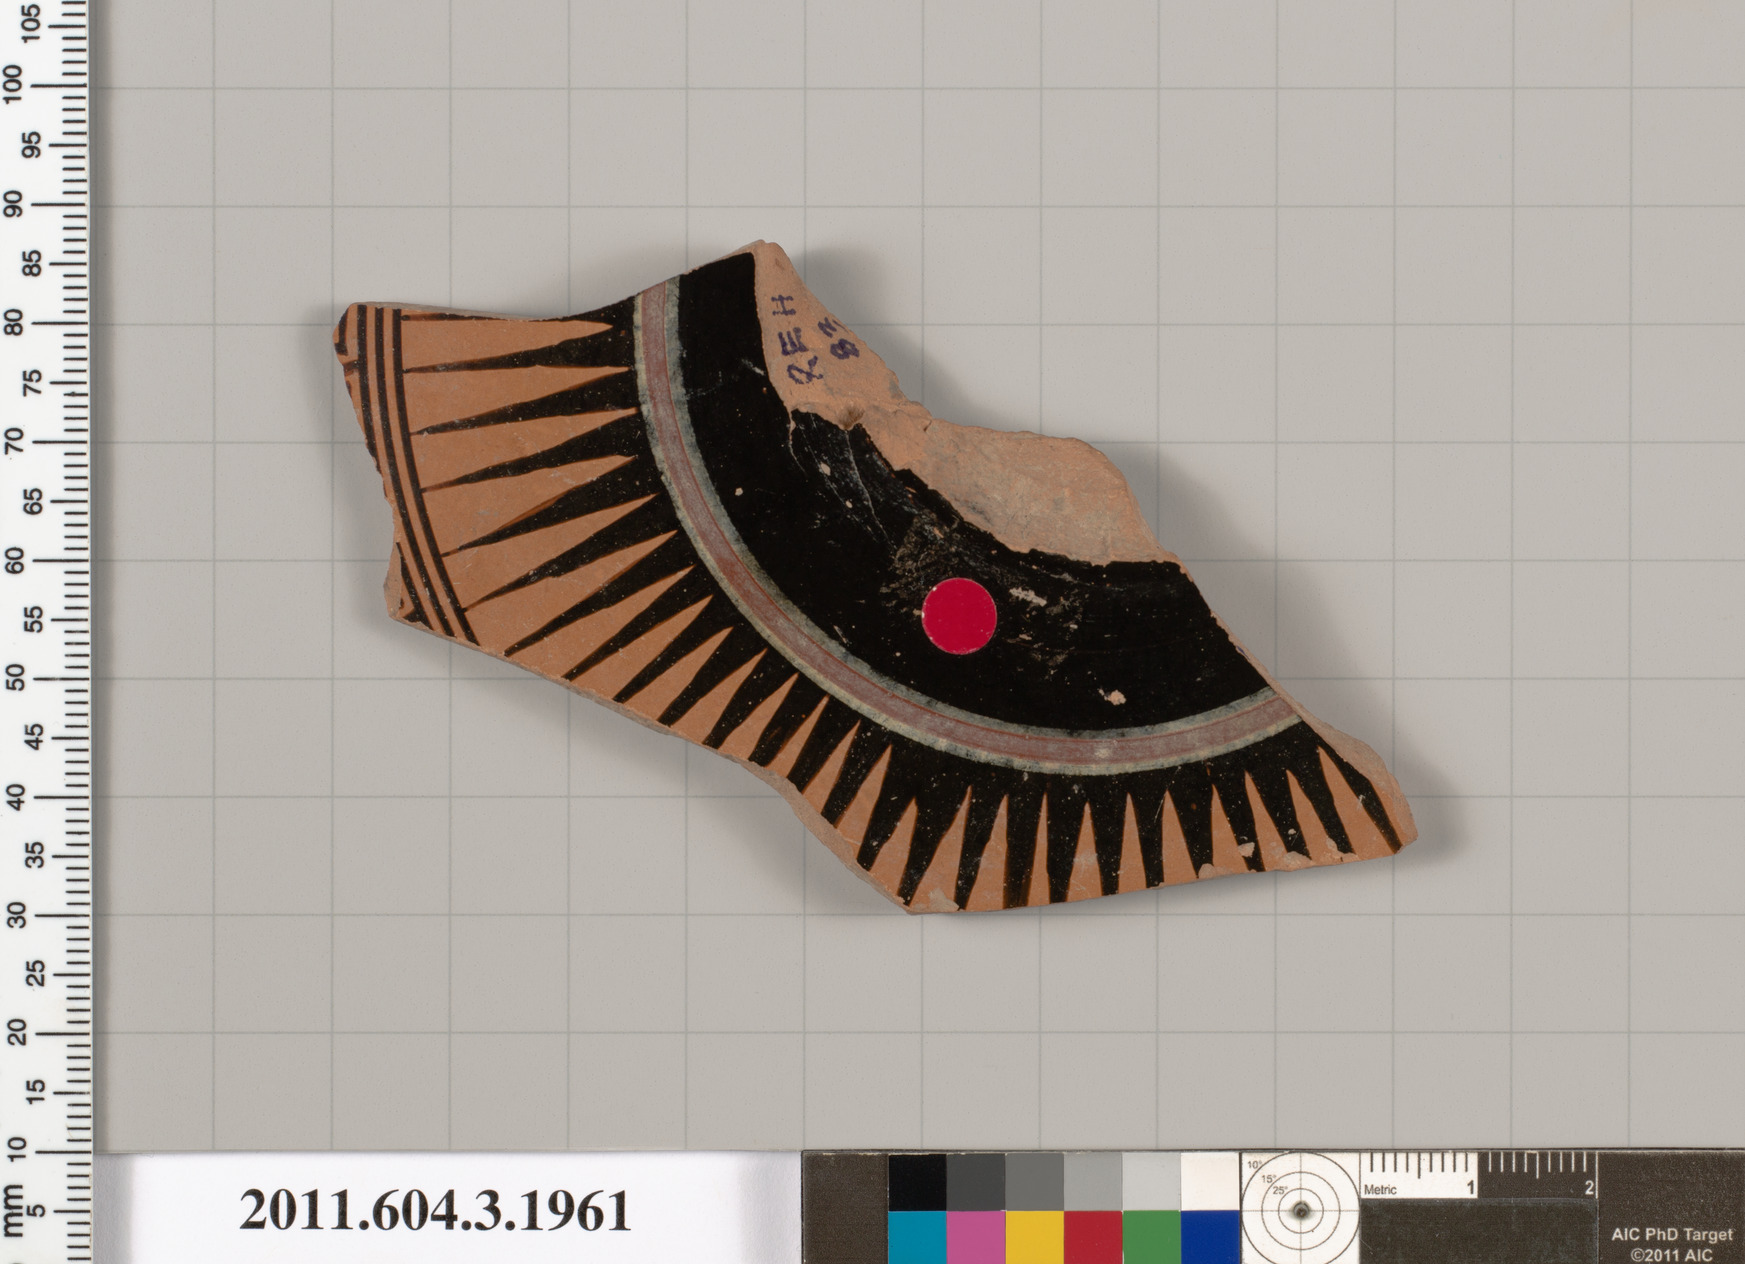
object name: kylix fragment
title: Terracotta fragment of a kylix (drinking cup)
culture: greek, attic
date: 560-550 BCE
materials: terracotta